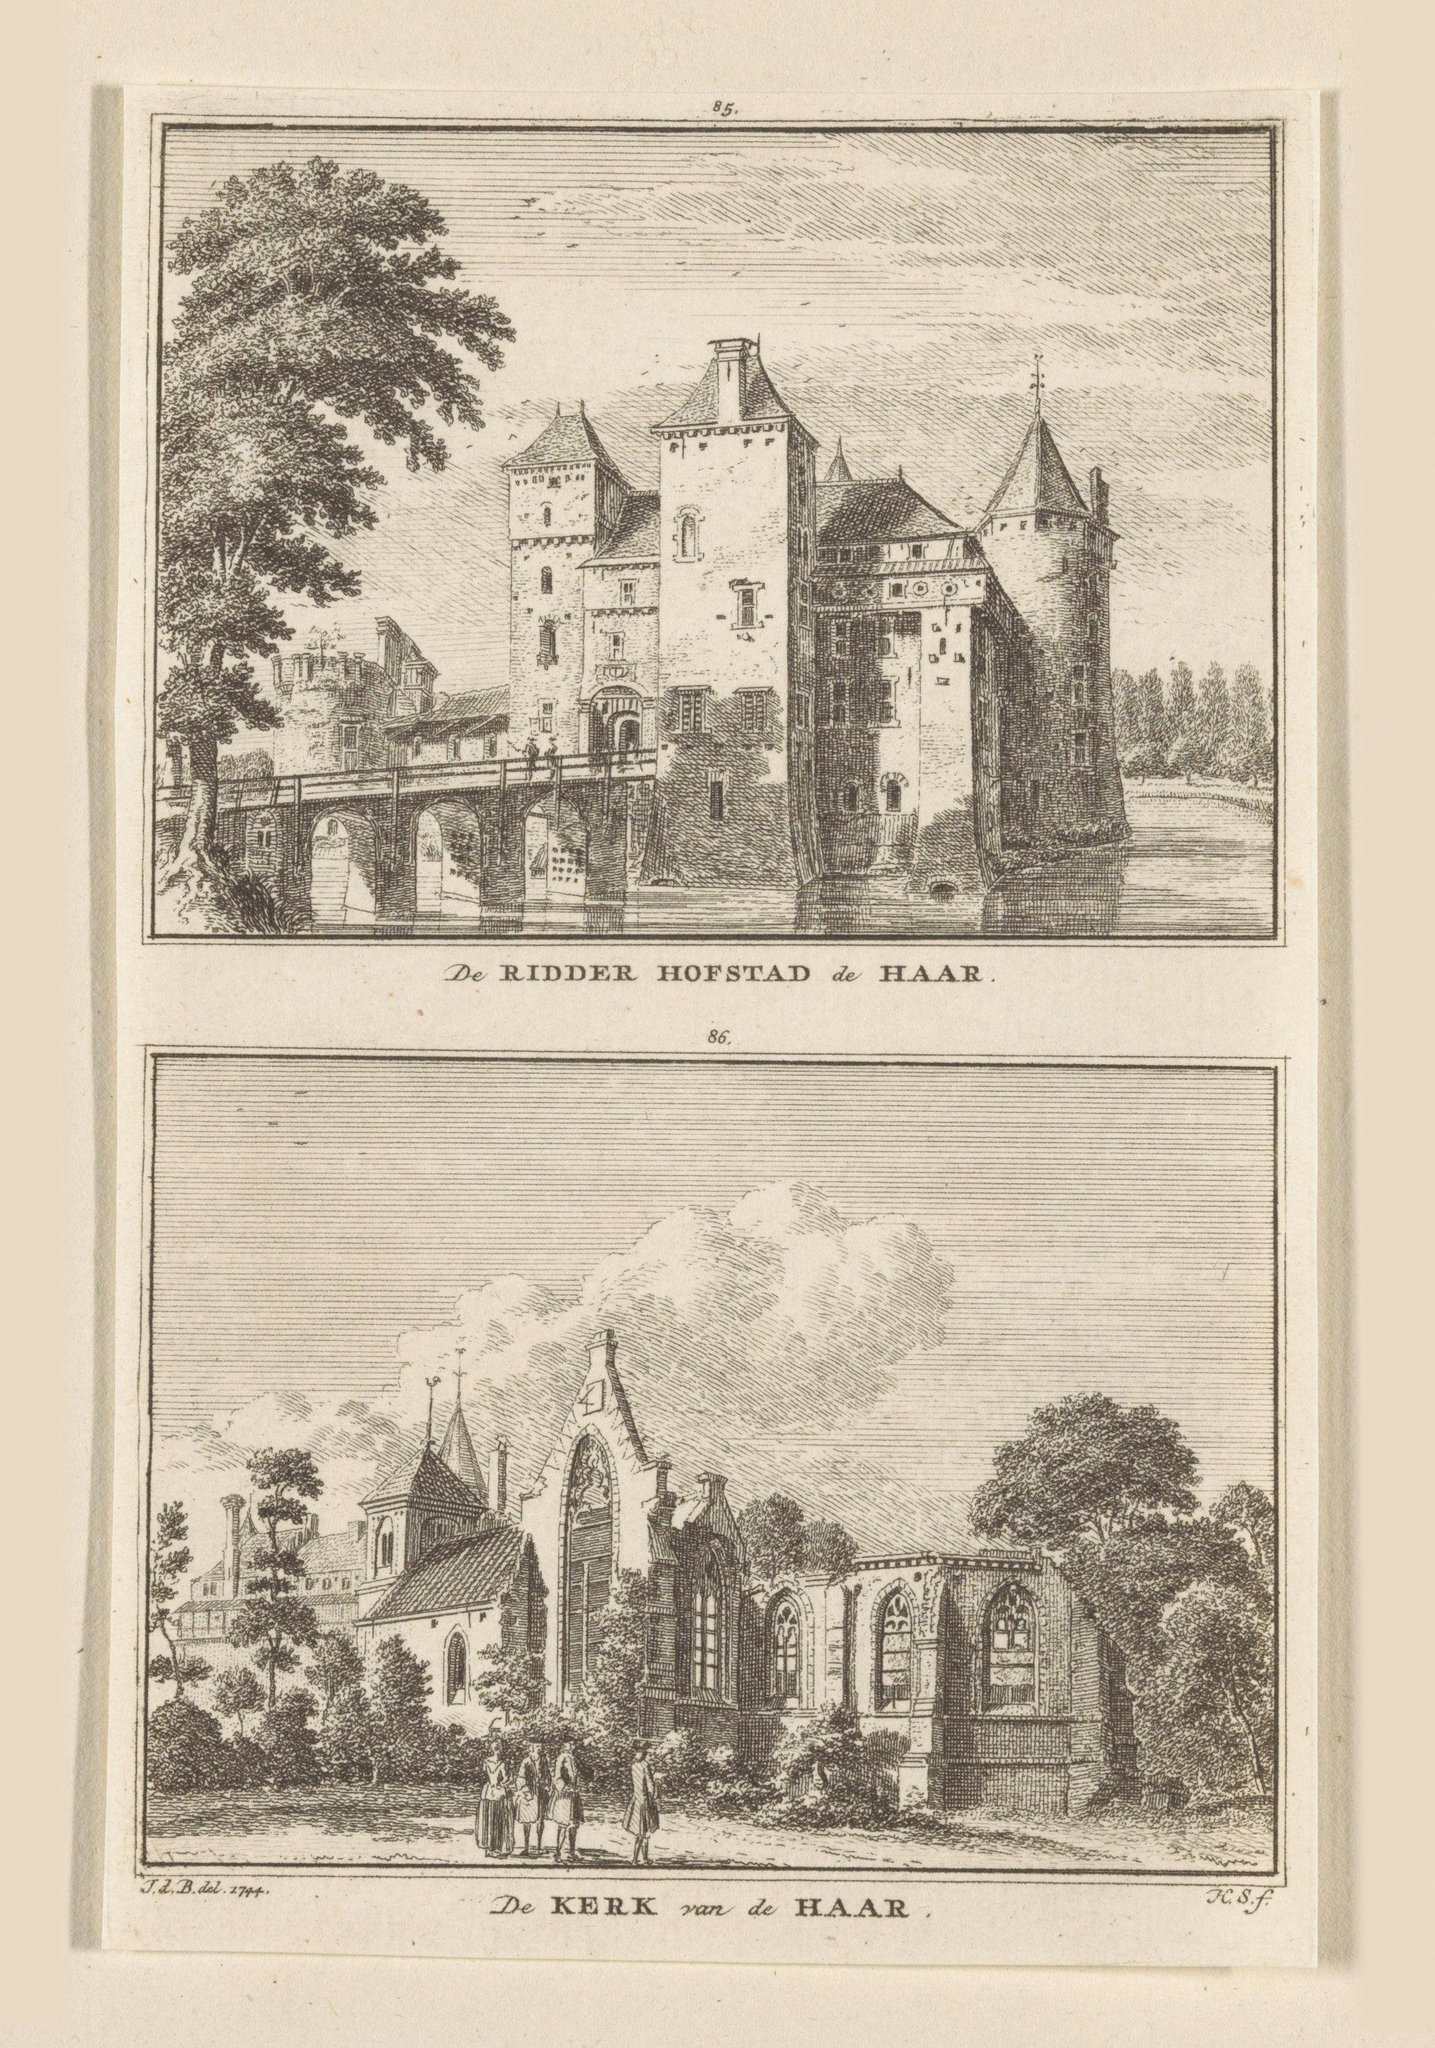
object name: book illustration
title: De kerk van De Haar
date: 1773-1792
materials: paper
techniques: engraving, etching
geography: haarlem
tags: parts of church exterior and annexes: chapel - qq - small church, chapel, castle, bridge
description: Prent ook gebruikt in: Het verheerlykt Nederland of kabinet van hedendaagsche gezigten van steden, dorpen (…). 9 delen. Amsterdam: Isaak Tirion en weduwe Isaak Tirion, 1745-1774, dl. 7, 8 of 9 (weduwe Isaak Tirion, 1773-1774), ill. 85 en 86. Of in: Nederlandsche tafereelen; of eene keurige verzameling van negen honderd fraaije gezigten van steden, dorpen, sloten, oudheden (….). 9 delen. Amsterdam: Jan de Groot, 1792, dl. 7, 8 of 9, ill. 85 en 86. Uit welke druk het huidige exemplaar precies komt is niet na te gaan.